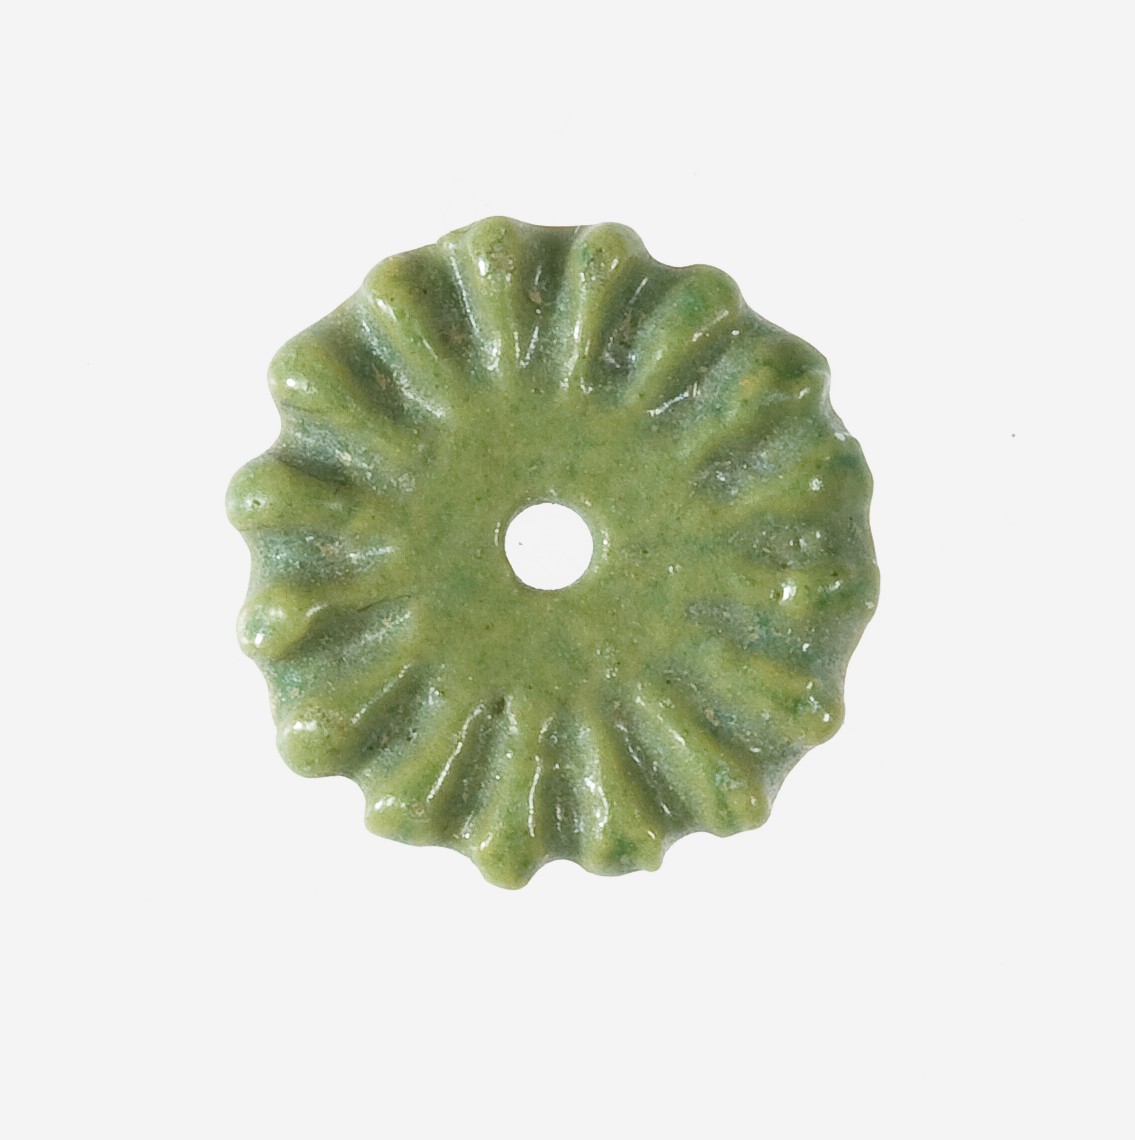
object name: pendant, rosette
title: Rosette Pendant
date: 1390-1352 BCE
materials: faience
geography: egypt